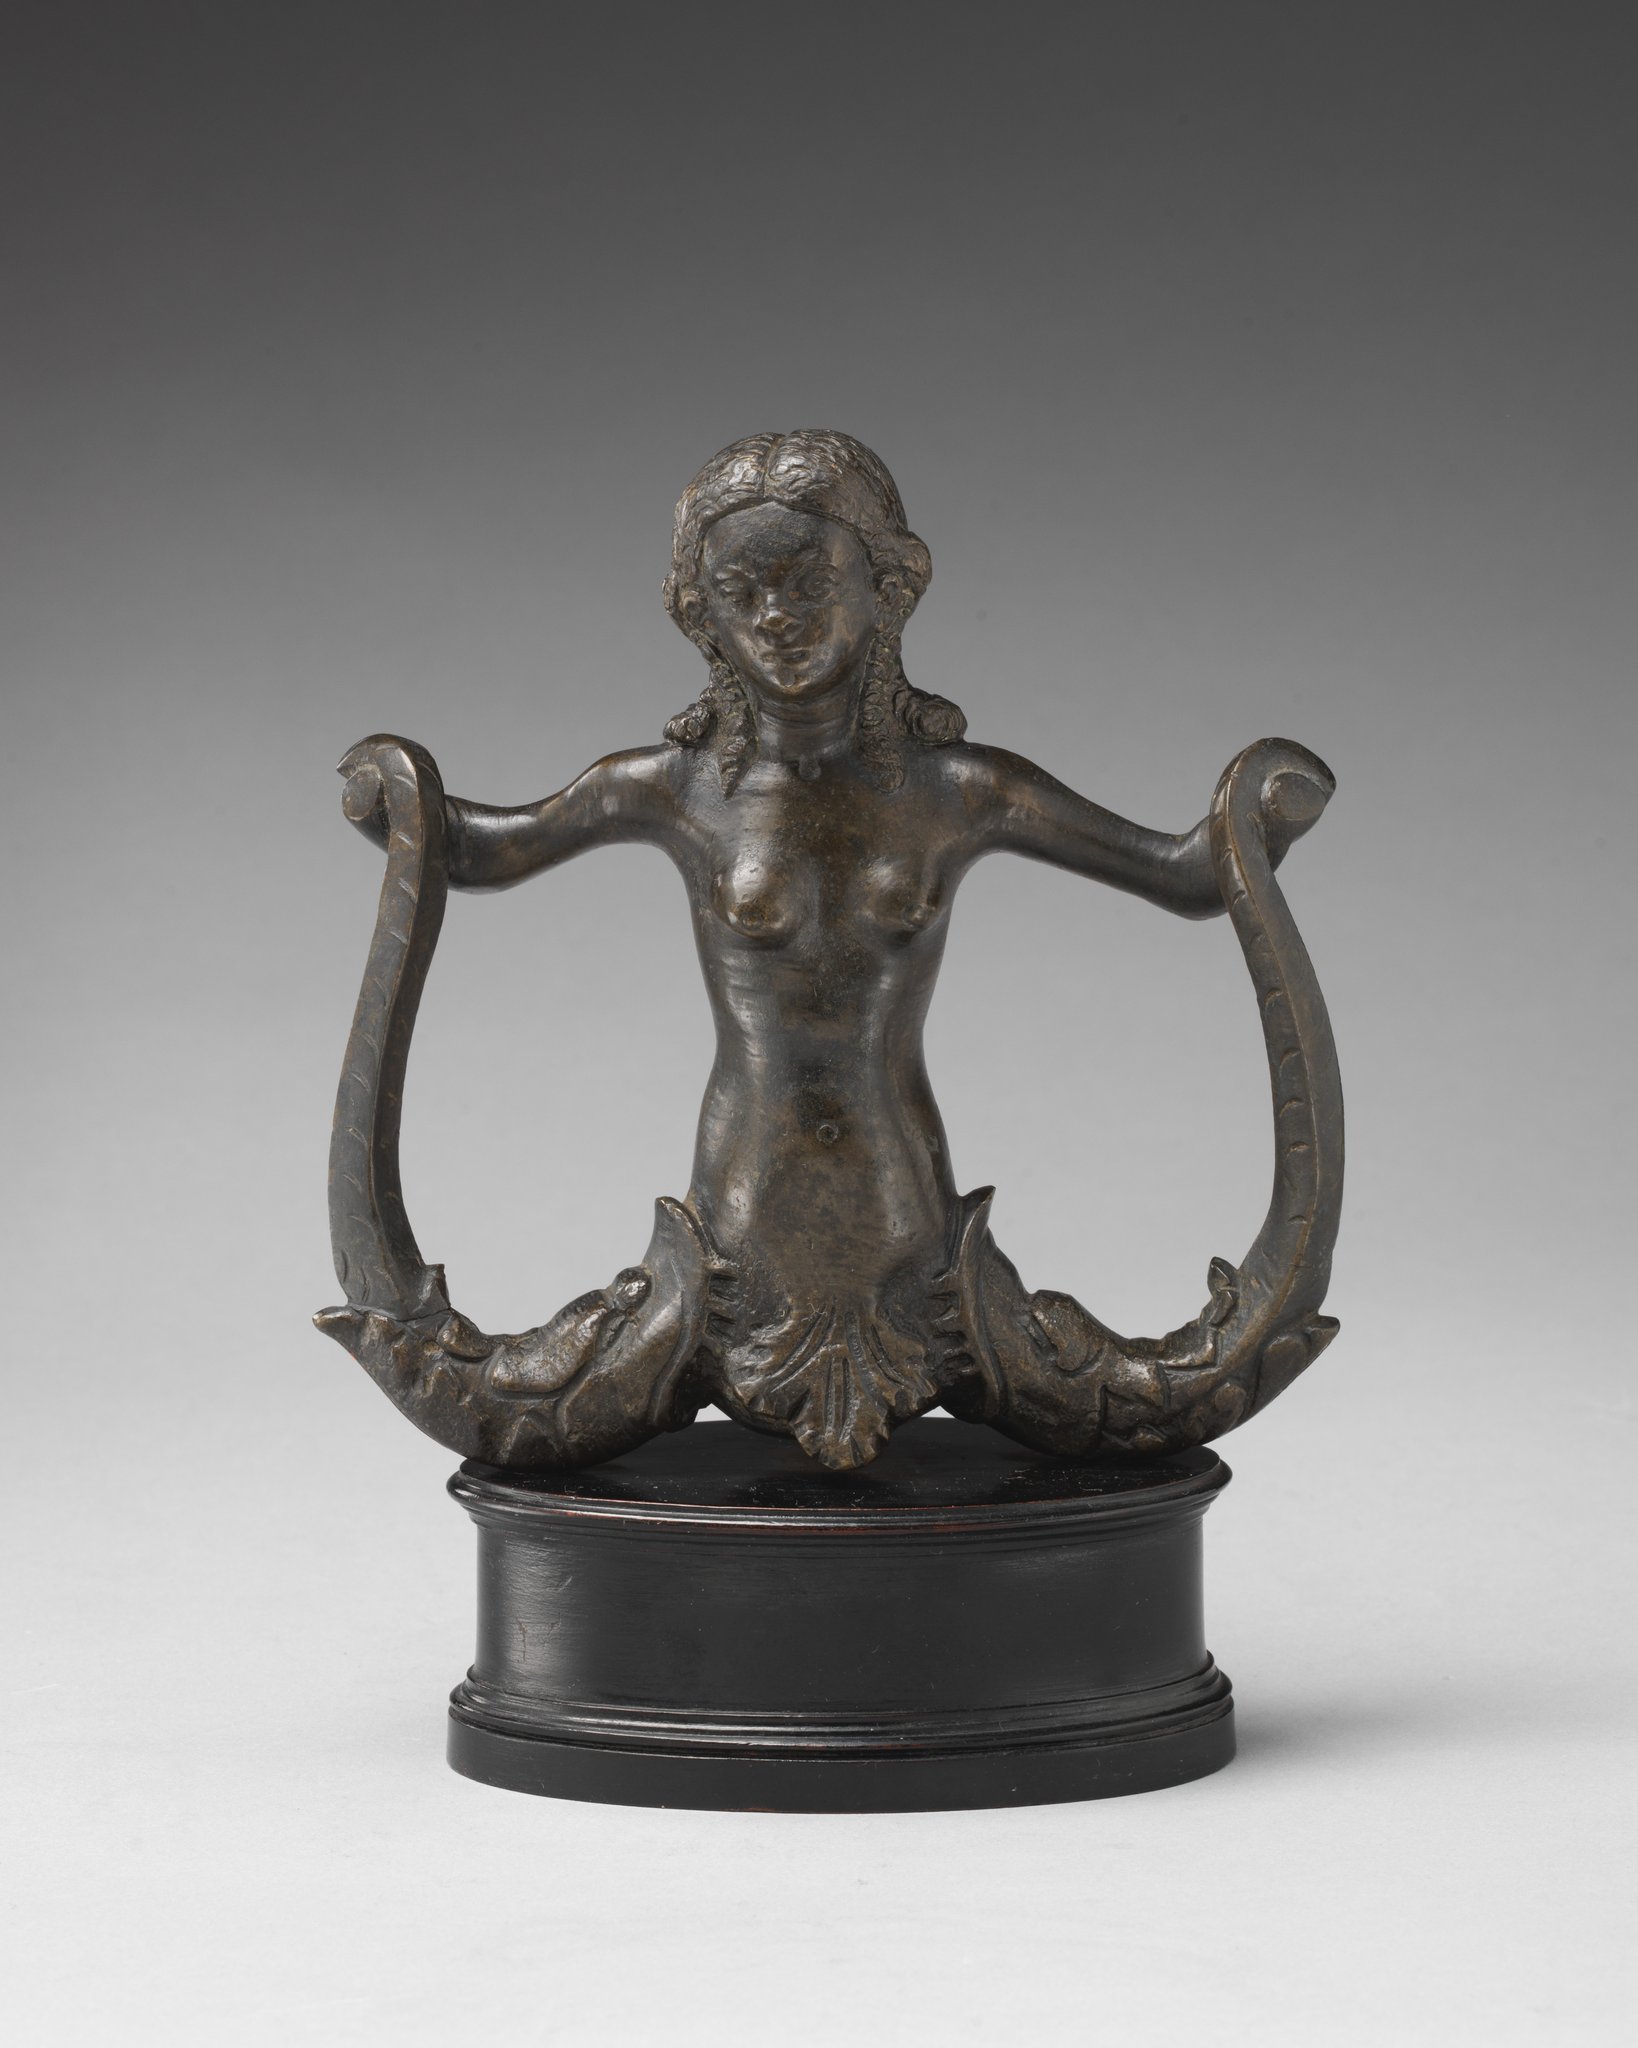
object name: statuette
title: Mermaid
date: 1501-1550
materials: bronze, lacquer, patina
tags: mermaids